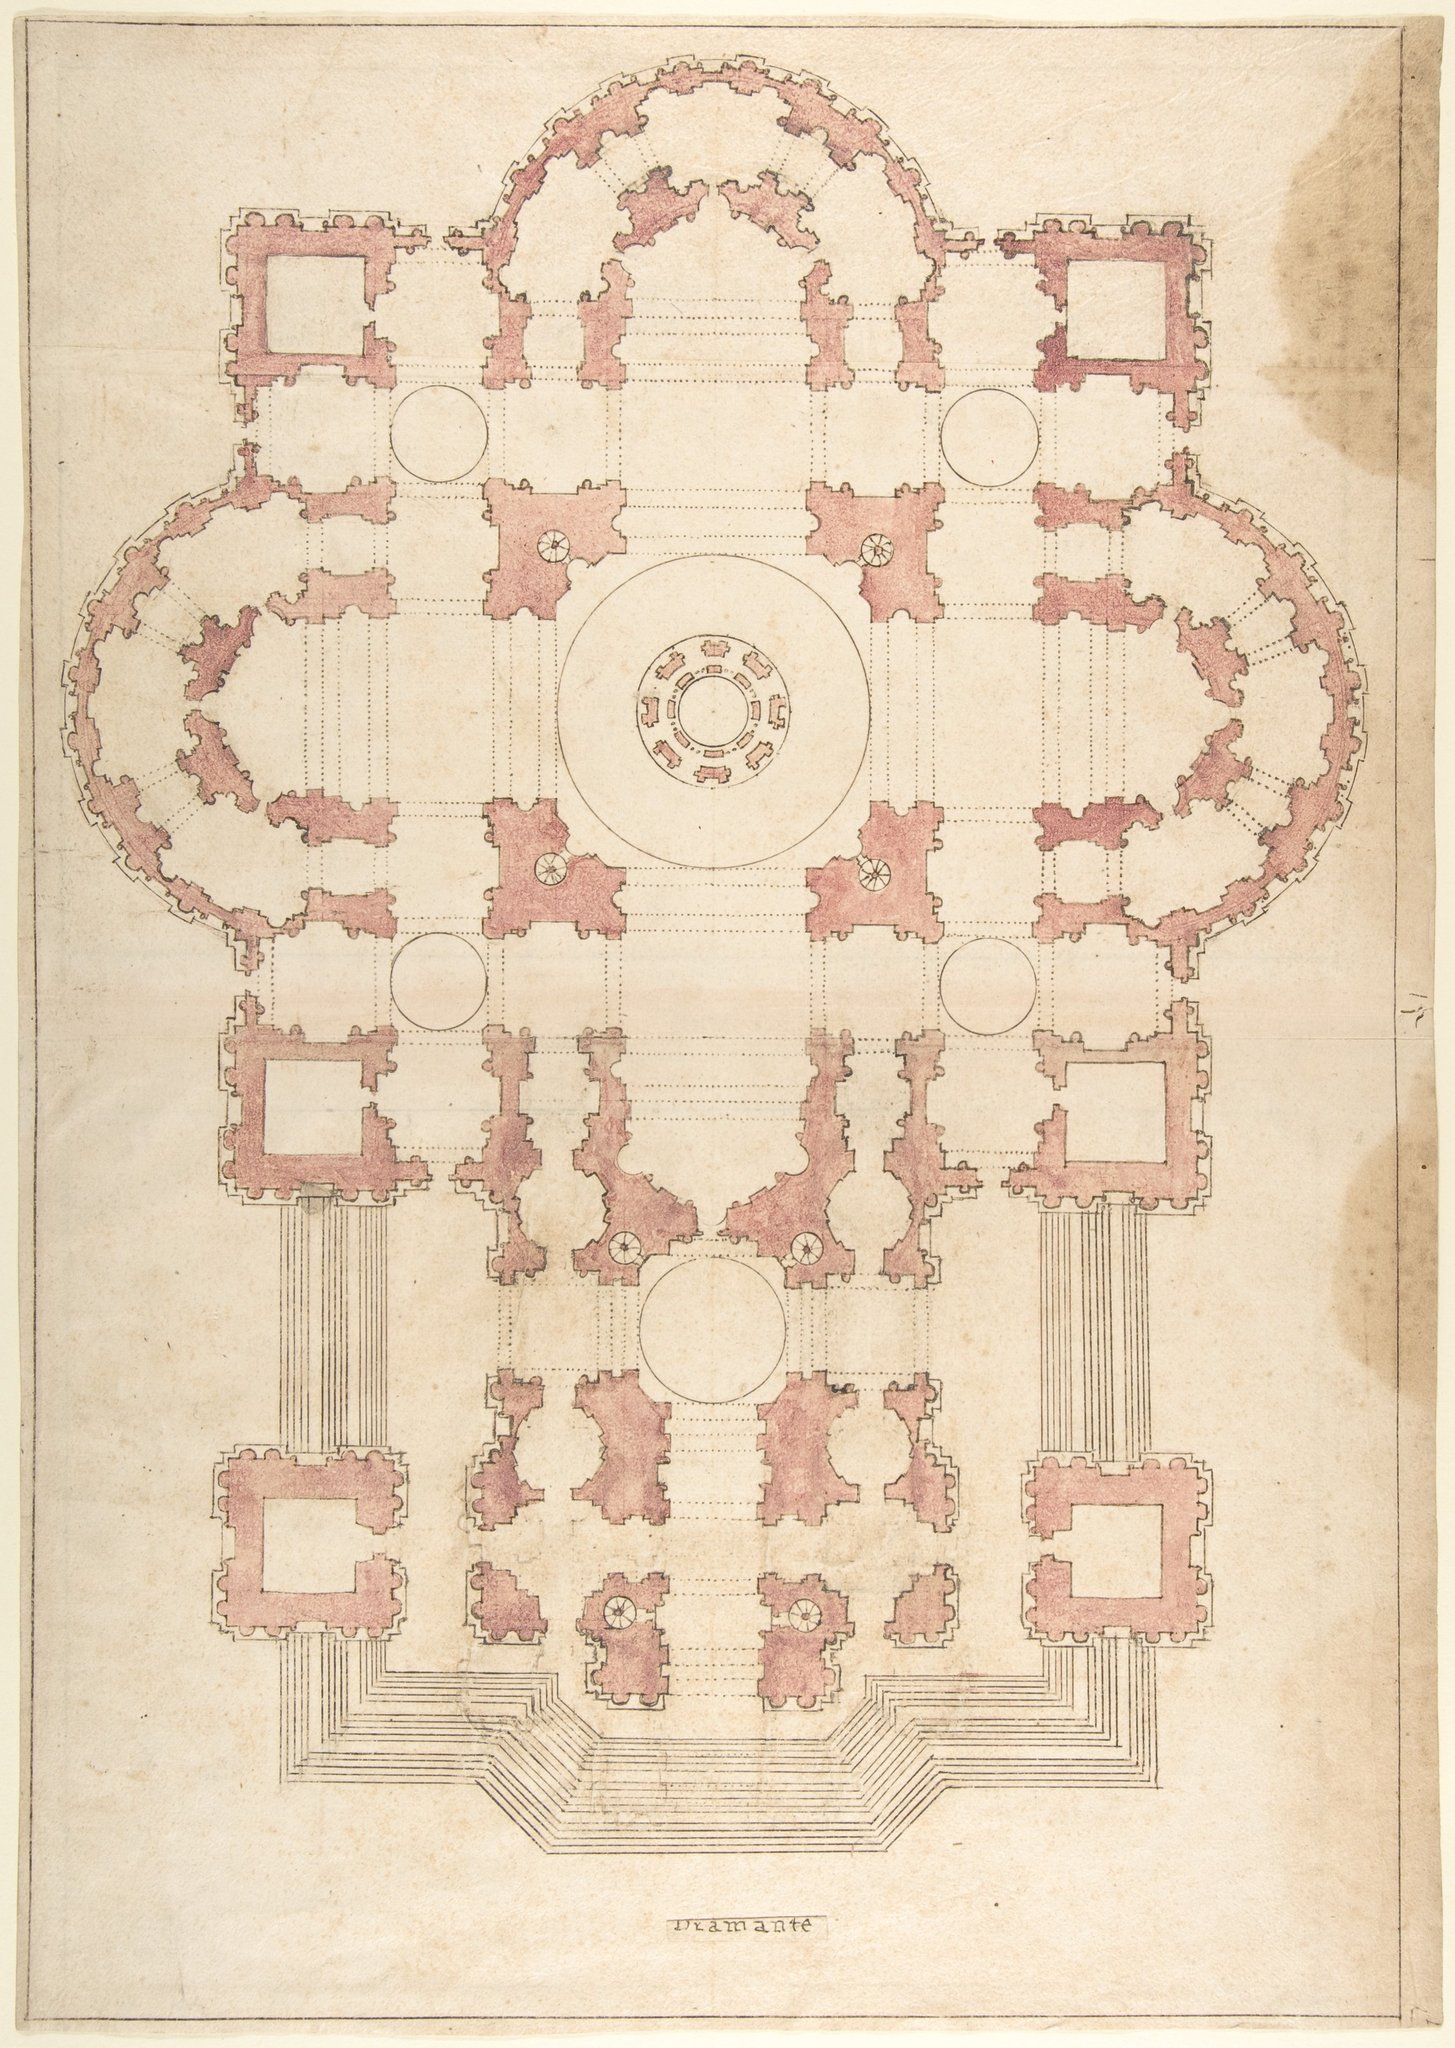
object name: drawing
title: Bramante's Plan for St. Peter's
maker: anonymous, italian, 16th to 17th century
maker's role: artist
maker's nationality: italian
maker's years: 1500-1700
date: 1501-1700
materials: ink, paper, watercolor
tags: architecture